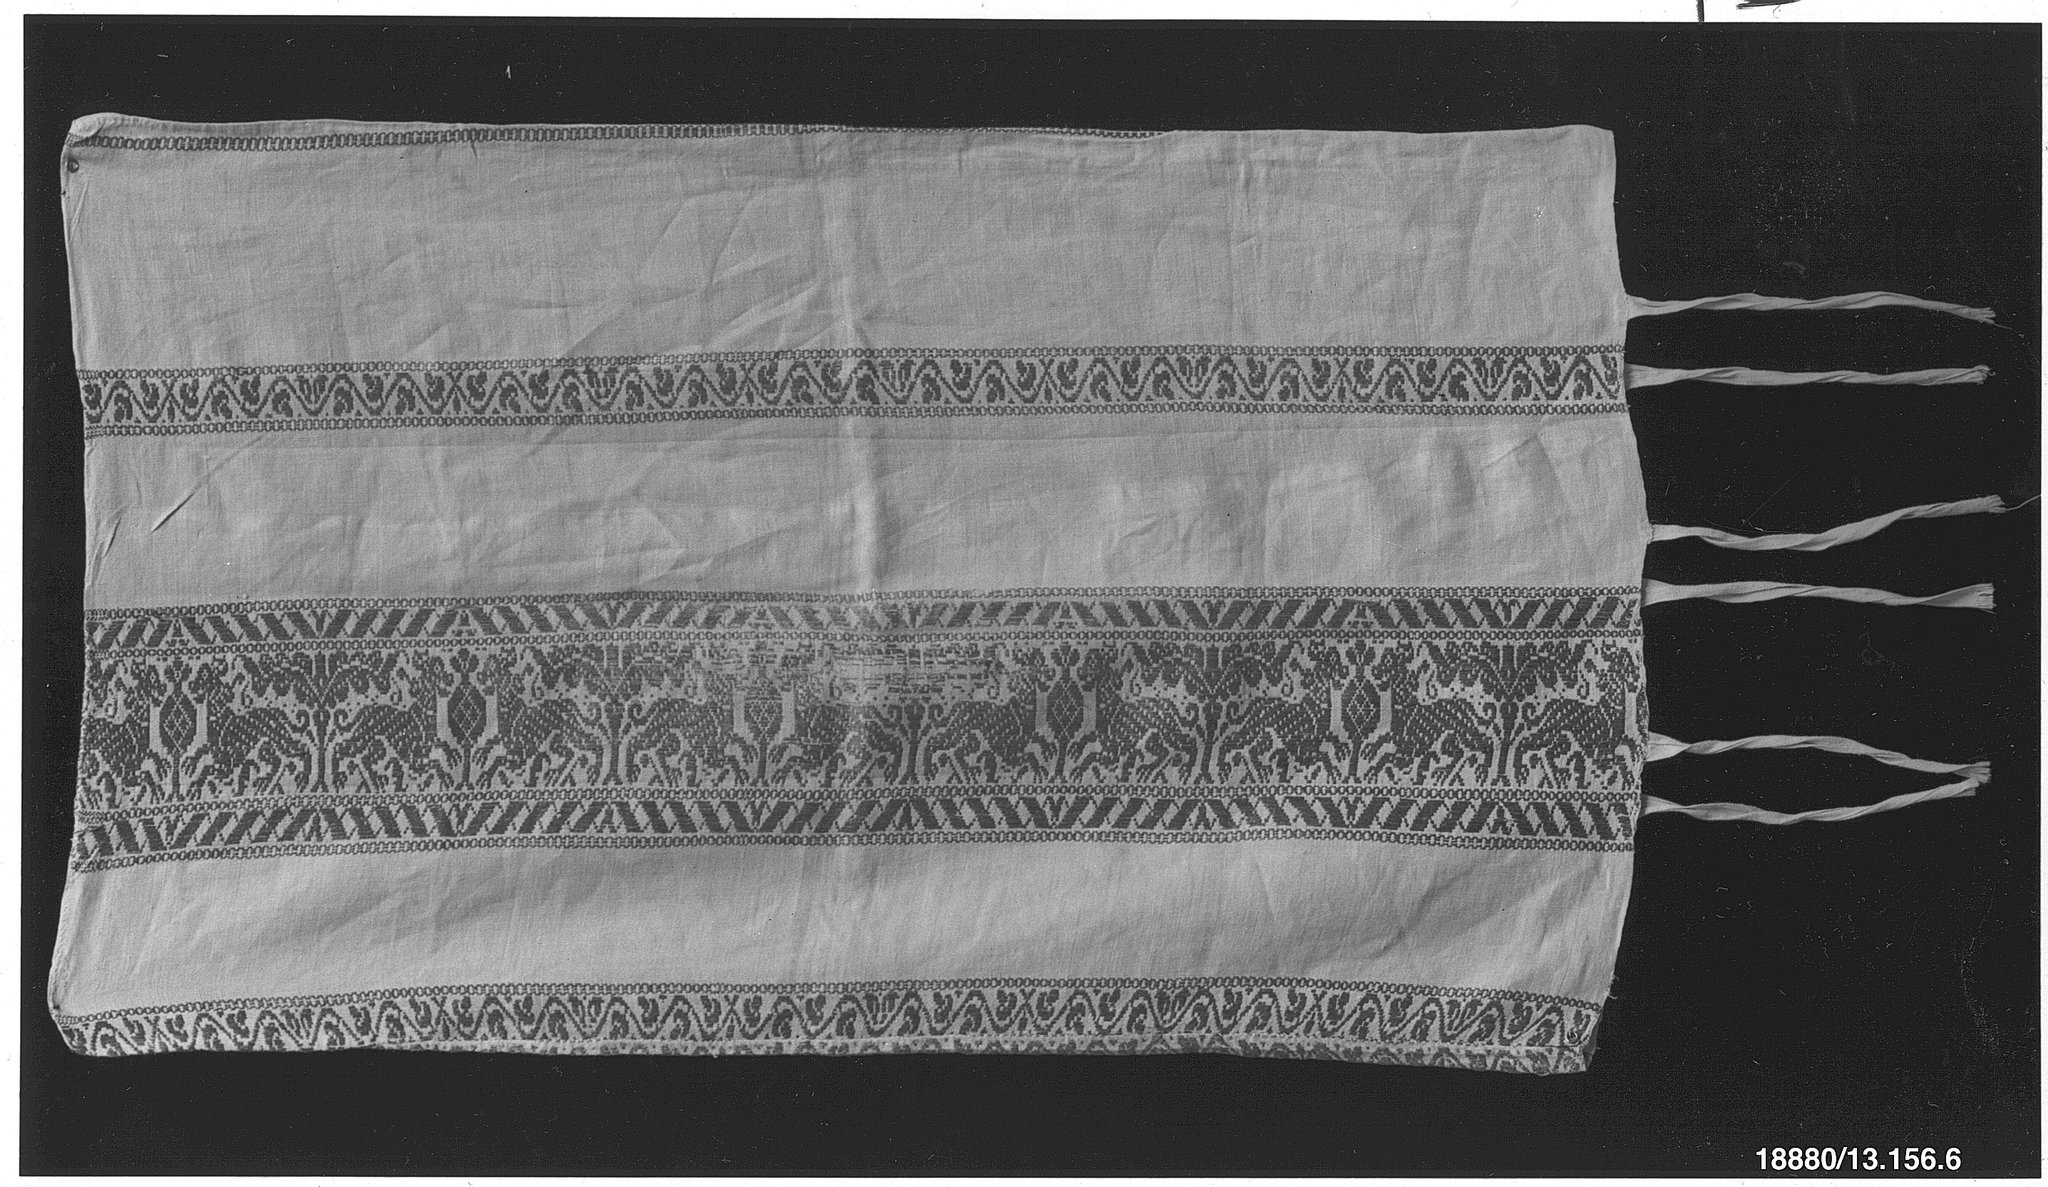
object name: pillow cover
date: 1501-1700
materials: cotton, linen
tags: animals